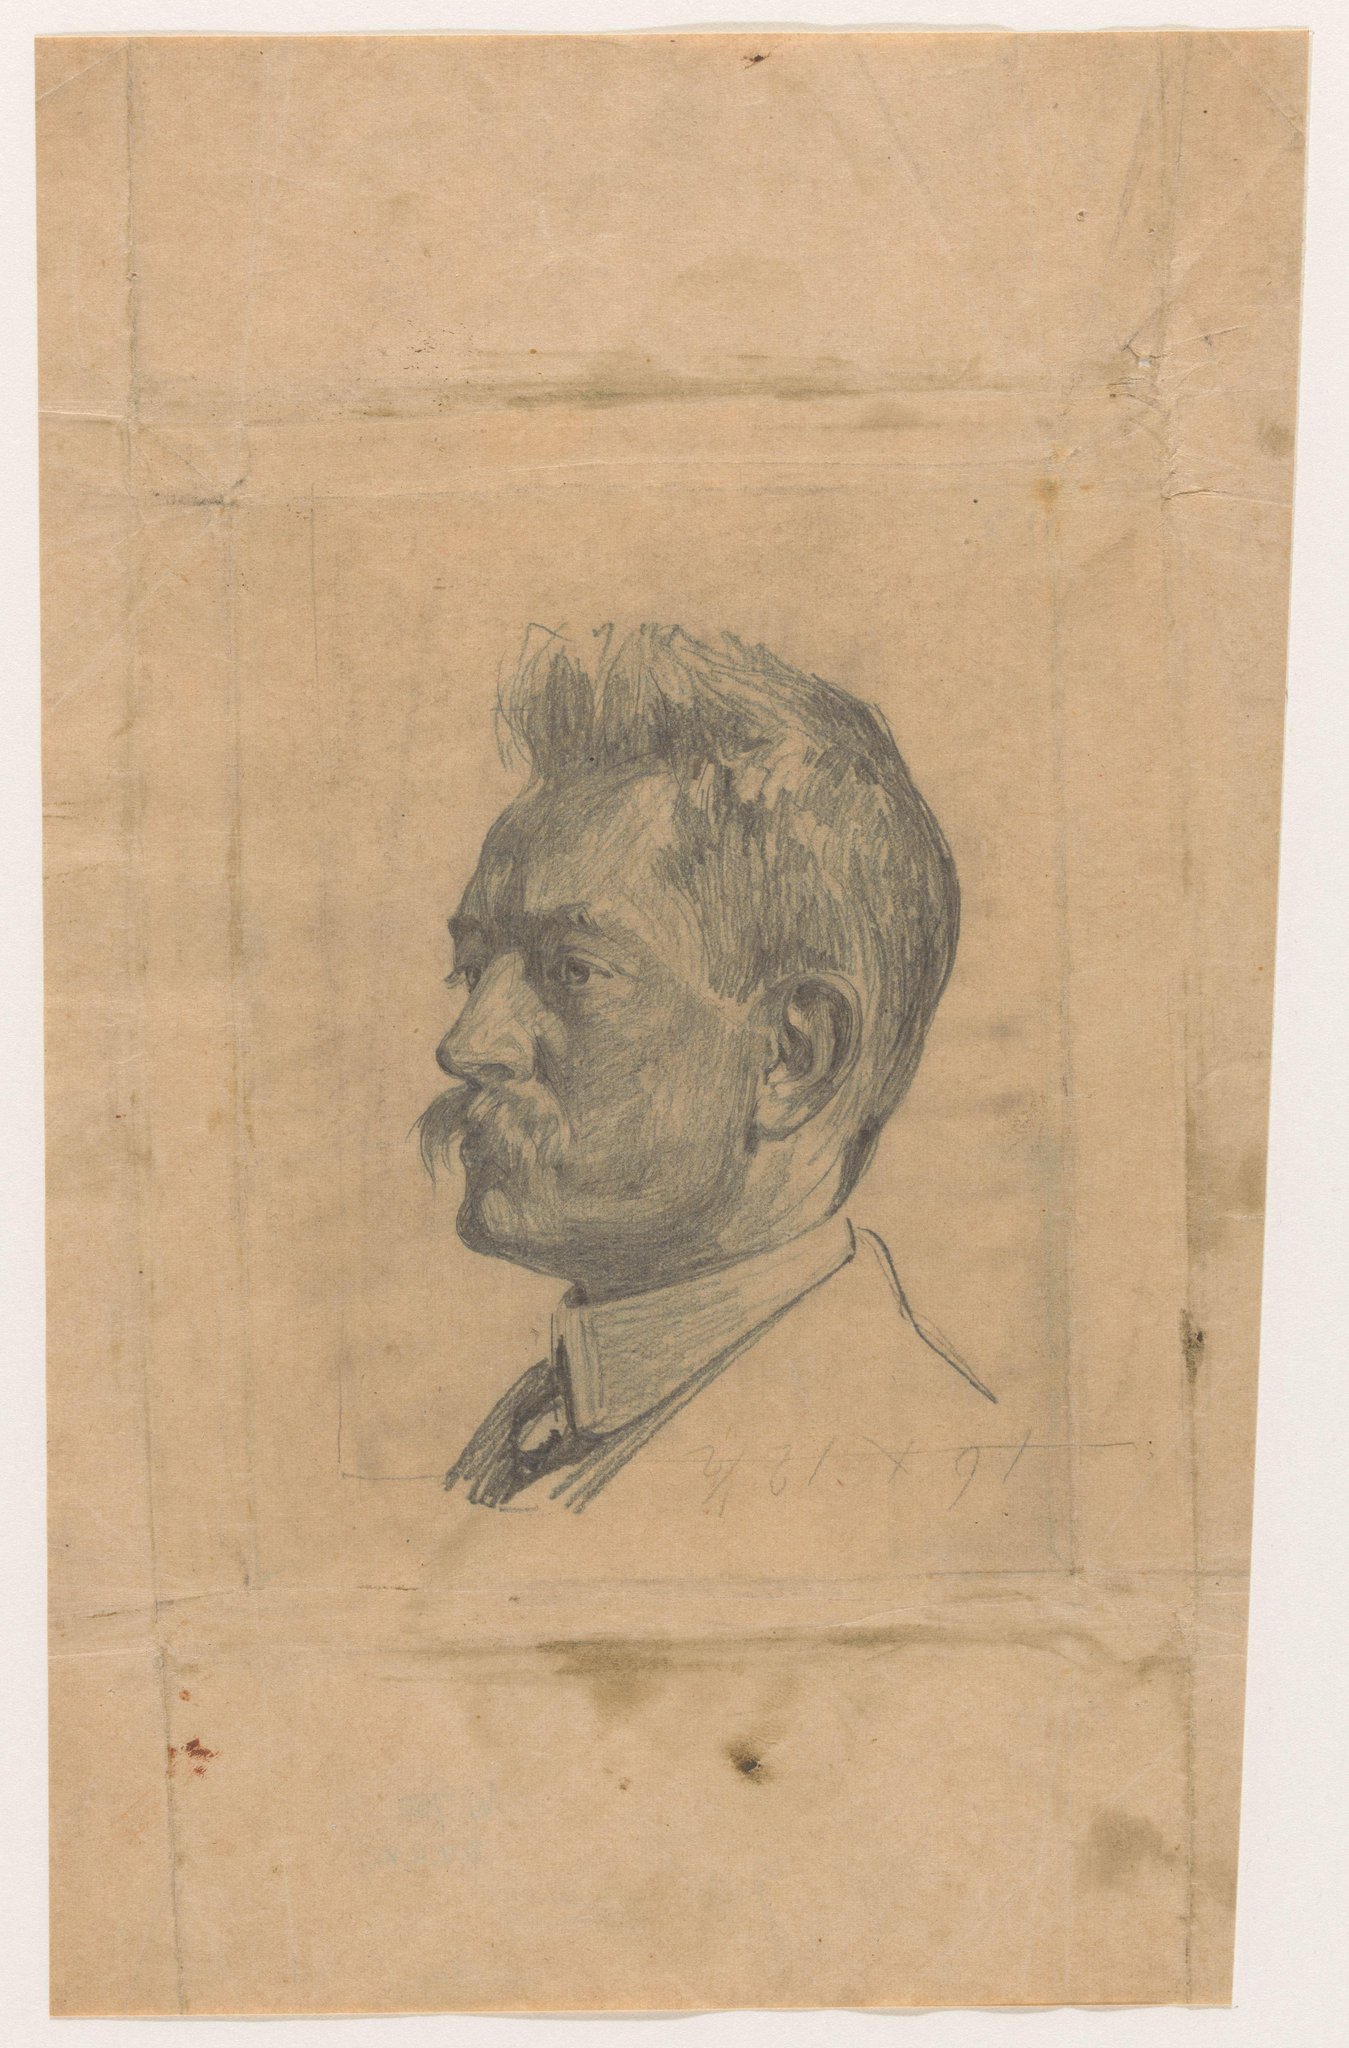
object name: design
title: Portret van Jan Hofker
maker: willem witsen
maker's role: draughtsman, painter, print maker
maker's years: 1860-1923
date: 1870-1923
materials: paper, pencil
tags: amsterdam, historical persons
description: Portret van Jan Hofker; op verso een afdruk van de vernis-mougrond. Ontwerp voor een prent.